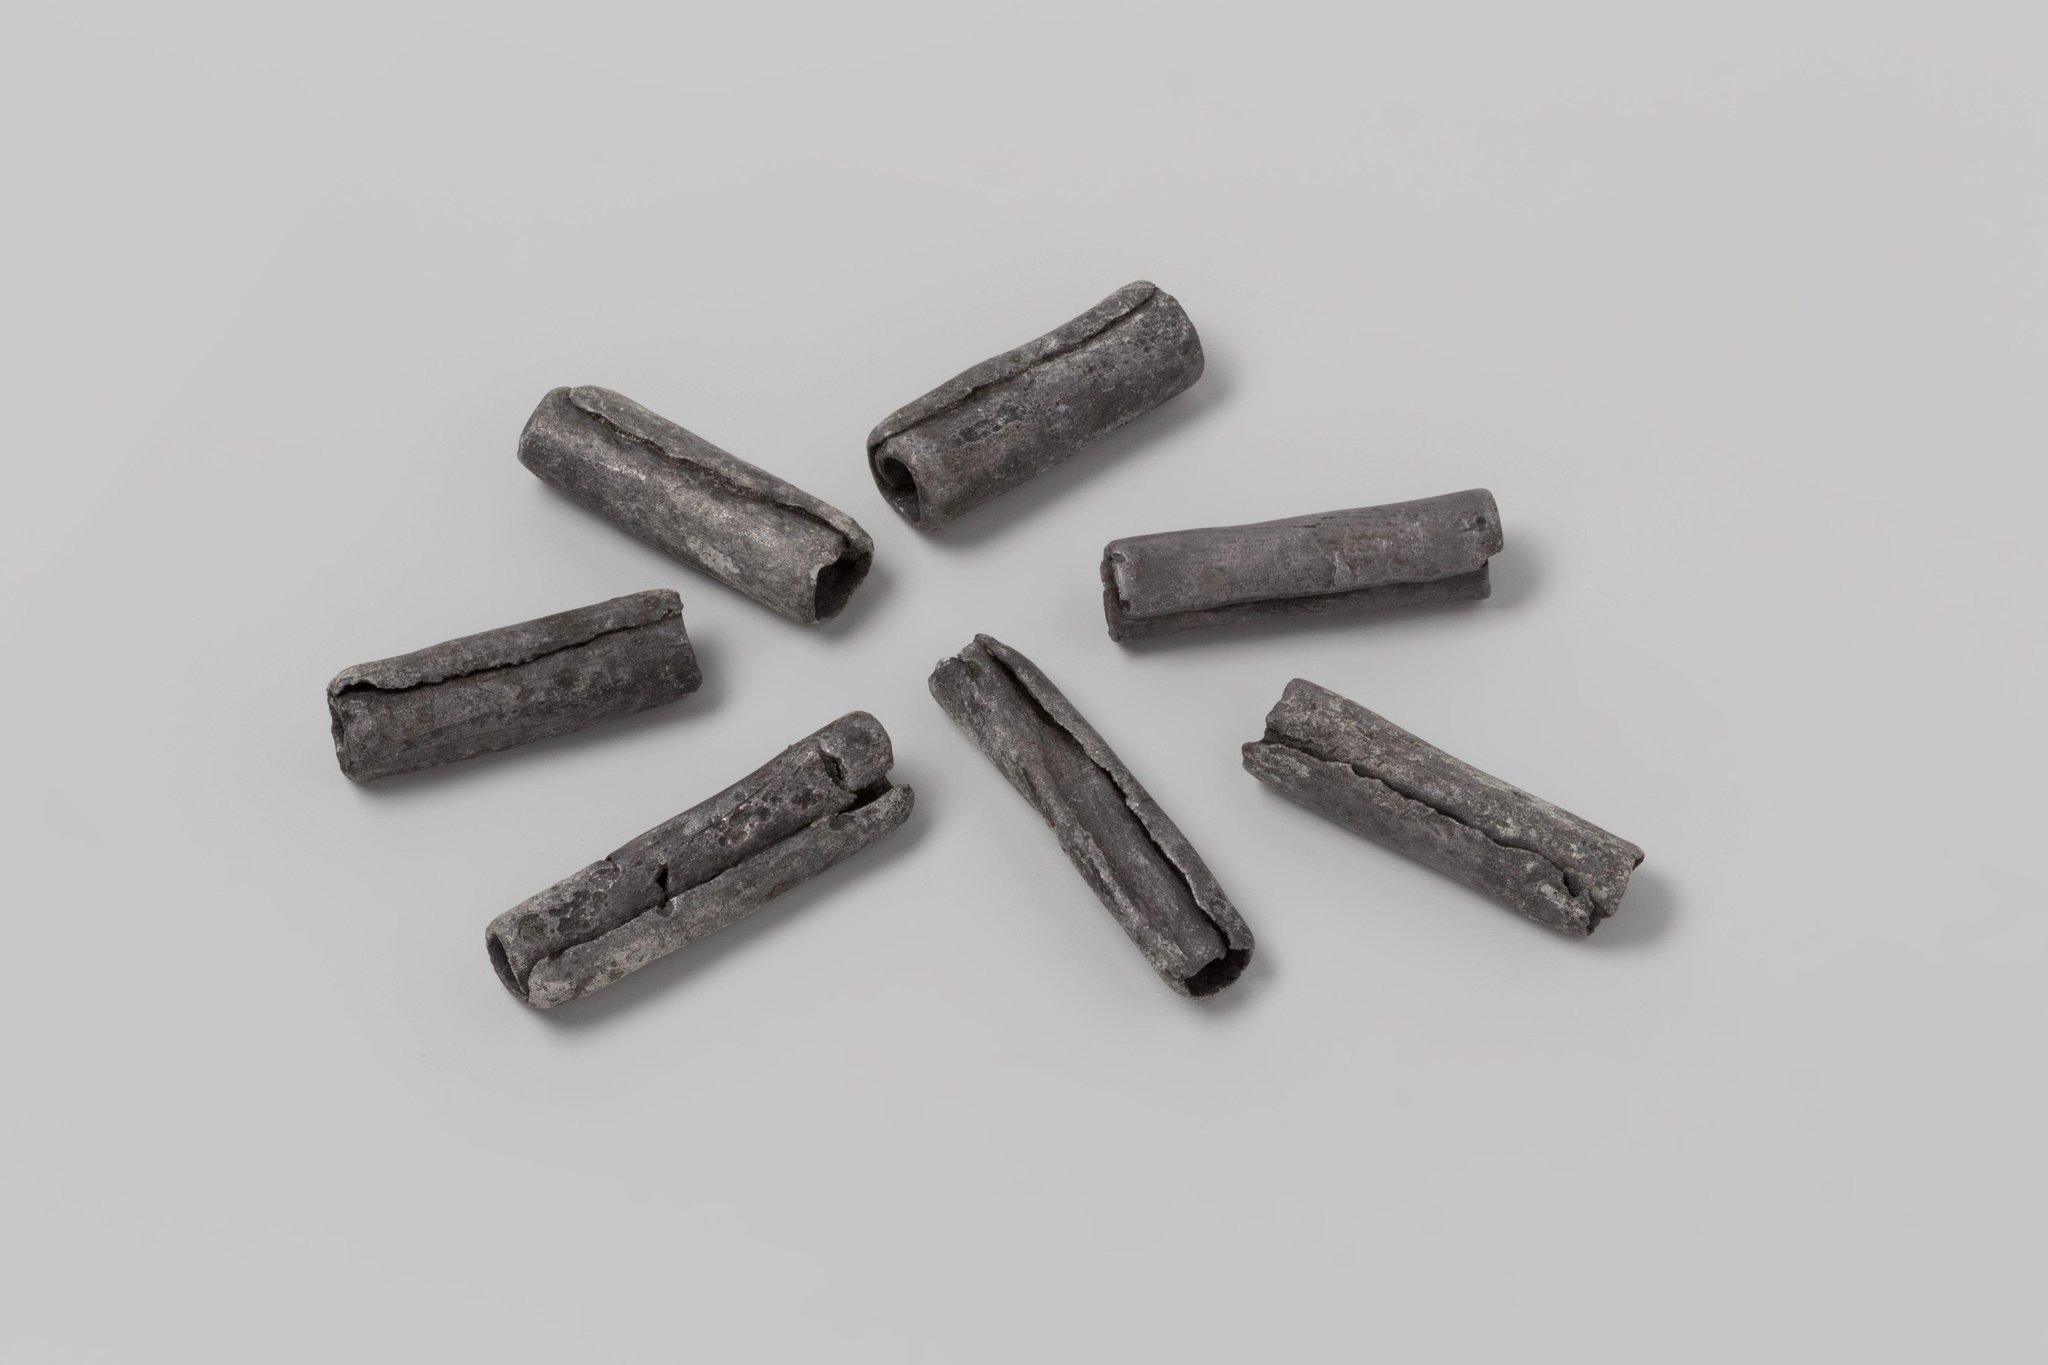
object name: lead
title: Loden rol uit het wrak van de Oost-Indiëvaarder 't Vliegend Hart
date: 1700-1735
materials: lead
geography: middelburg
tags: 't vliegend hart (schip), verenigde oostindische compagnie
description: Deze loden buisjes zijn vermoedelijk afkomstig van visnetten ofwel op TVliegend Hart zelf ofwel van vissers die hun netten aan het wrak verloren.